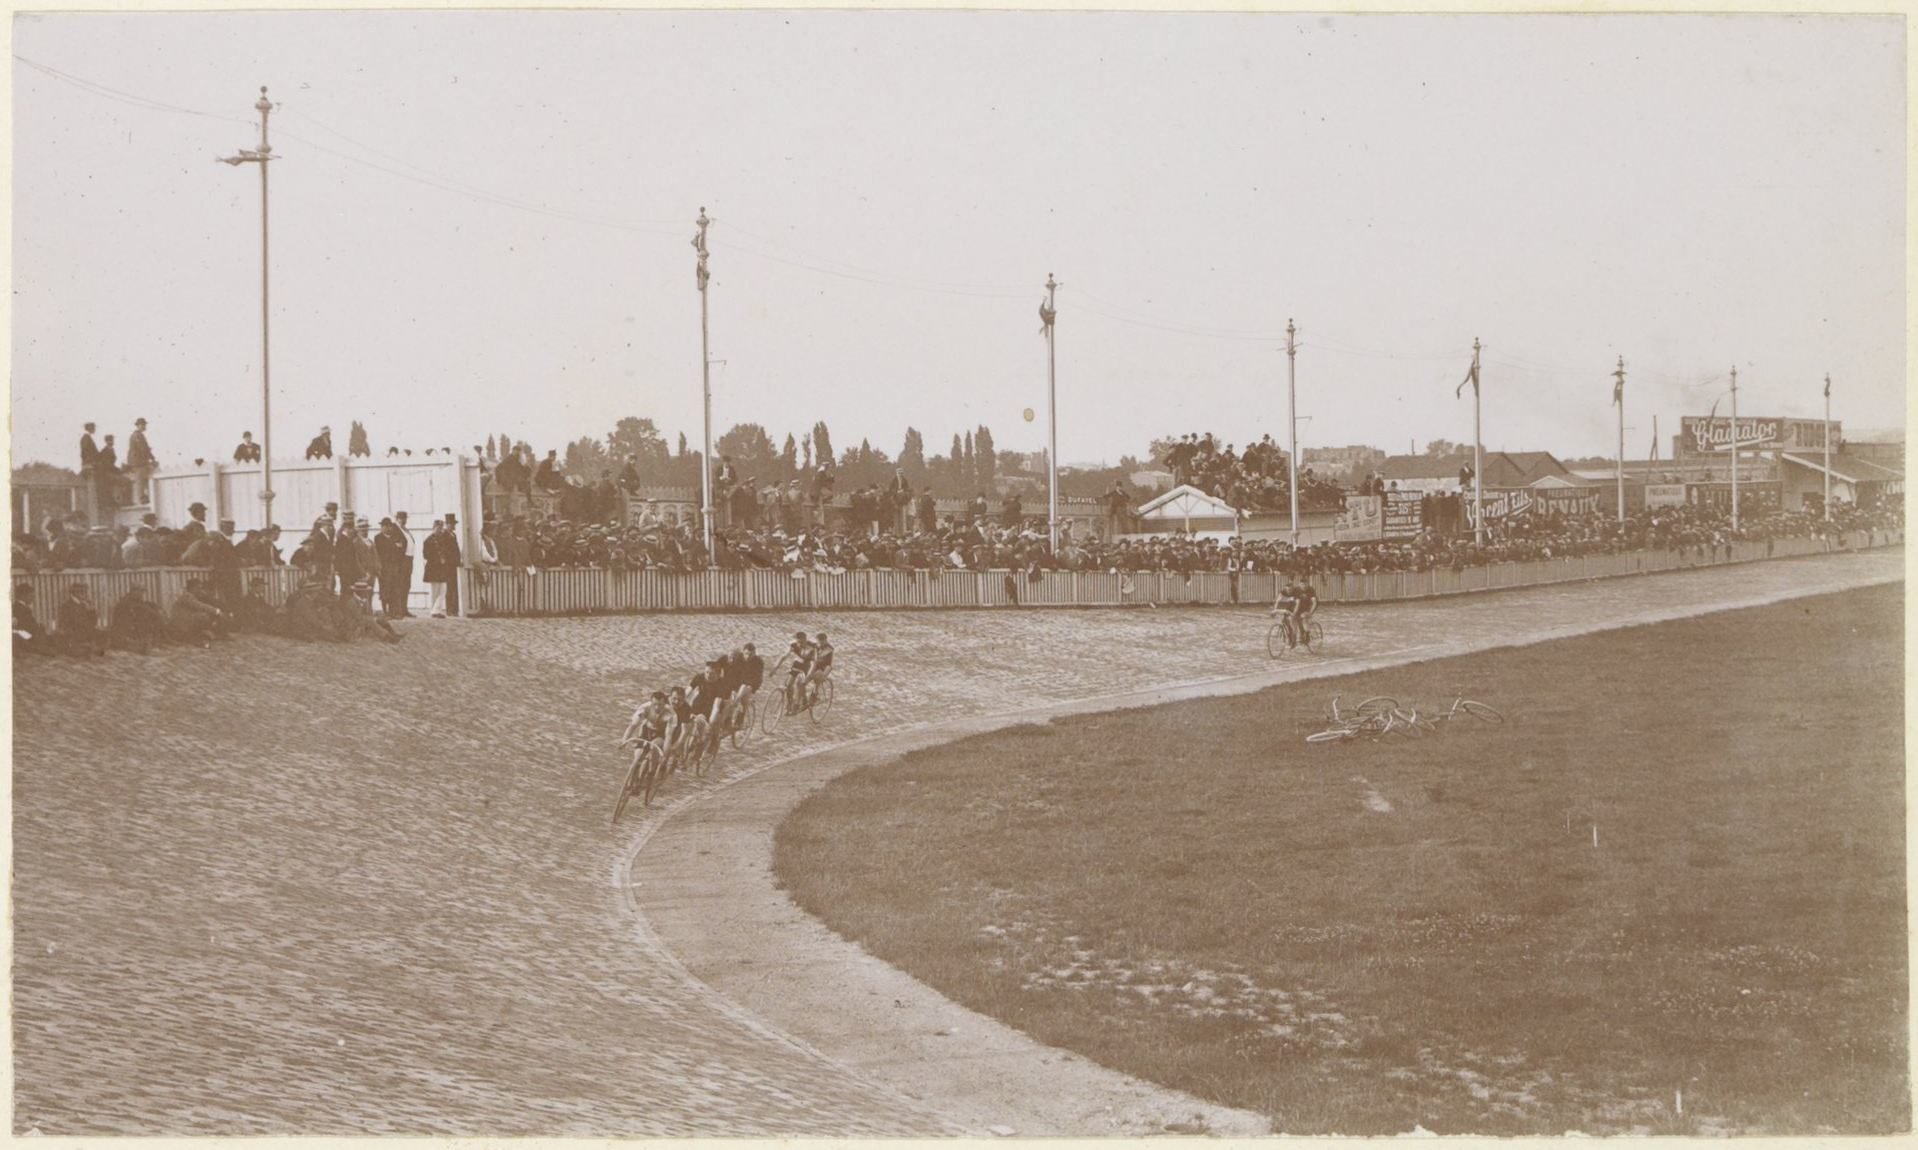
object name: photograph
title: Wielrenners op de Vélodrome de la Seine in Levallois-Perret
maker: Anonymous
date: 1900-1910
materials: paper, photographic support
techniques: daylight paper print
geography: levallois-perret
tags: bicycle racing (+ sportsman, player, etc.), grounds, fields and accomodations for sports, games and physical performances (+ out of doors (sports, games, etc.))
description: Onderdeel van Fotoalbum van een Franse amateurfotograaf met opnames van een familie, distilleerderij Delizy & Doistau Fils, het leger en bezienswaardigheden in Frankrijk.